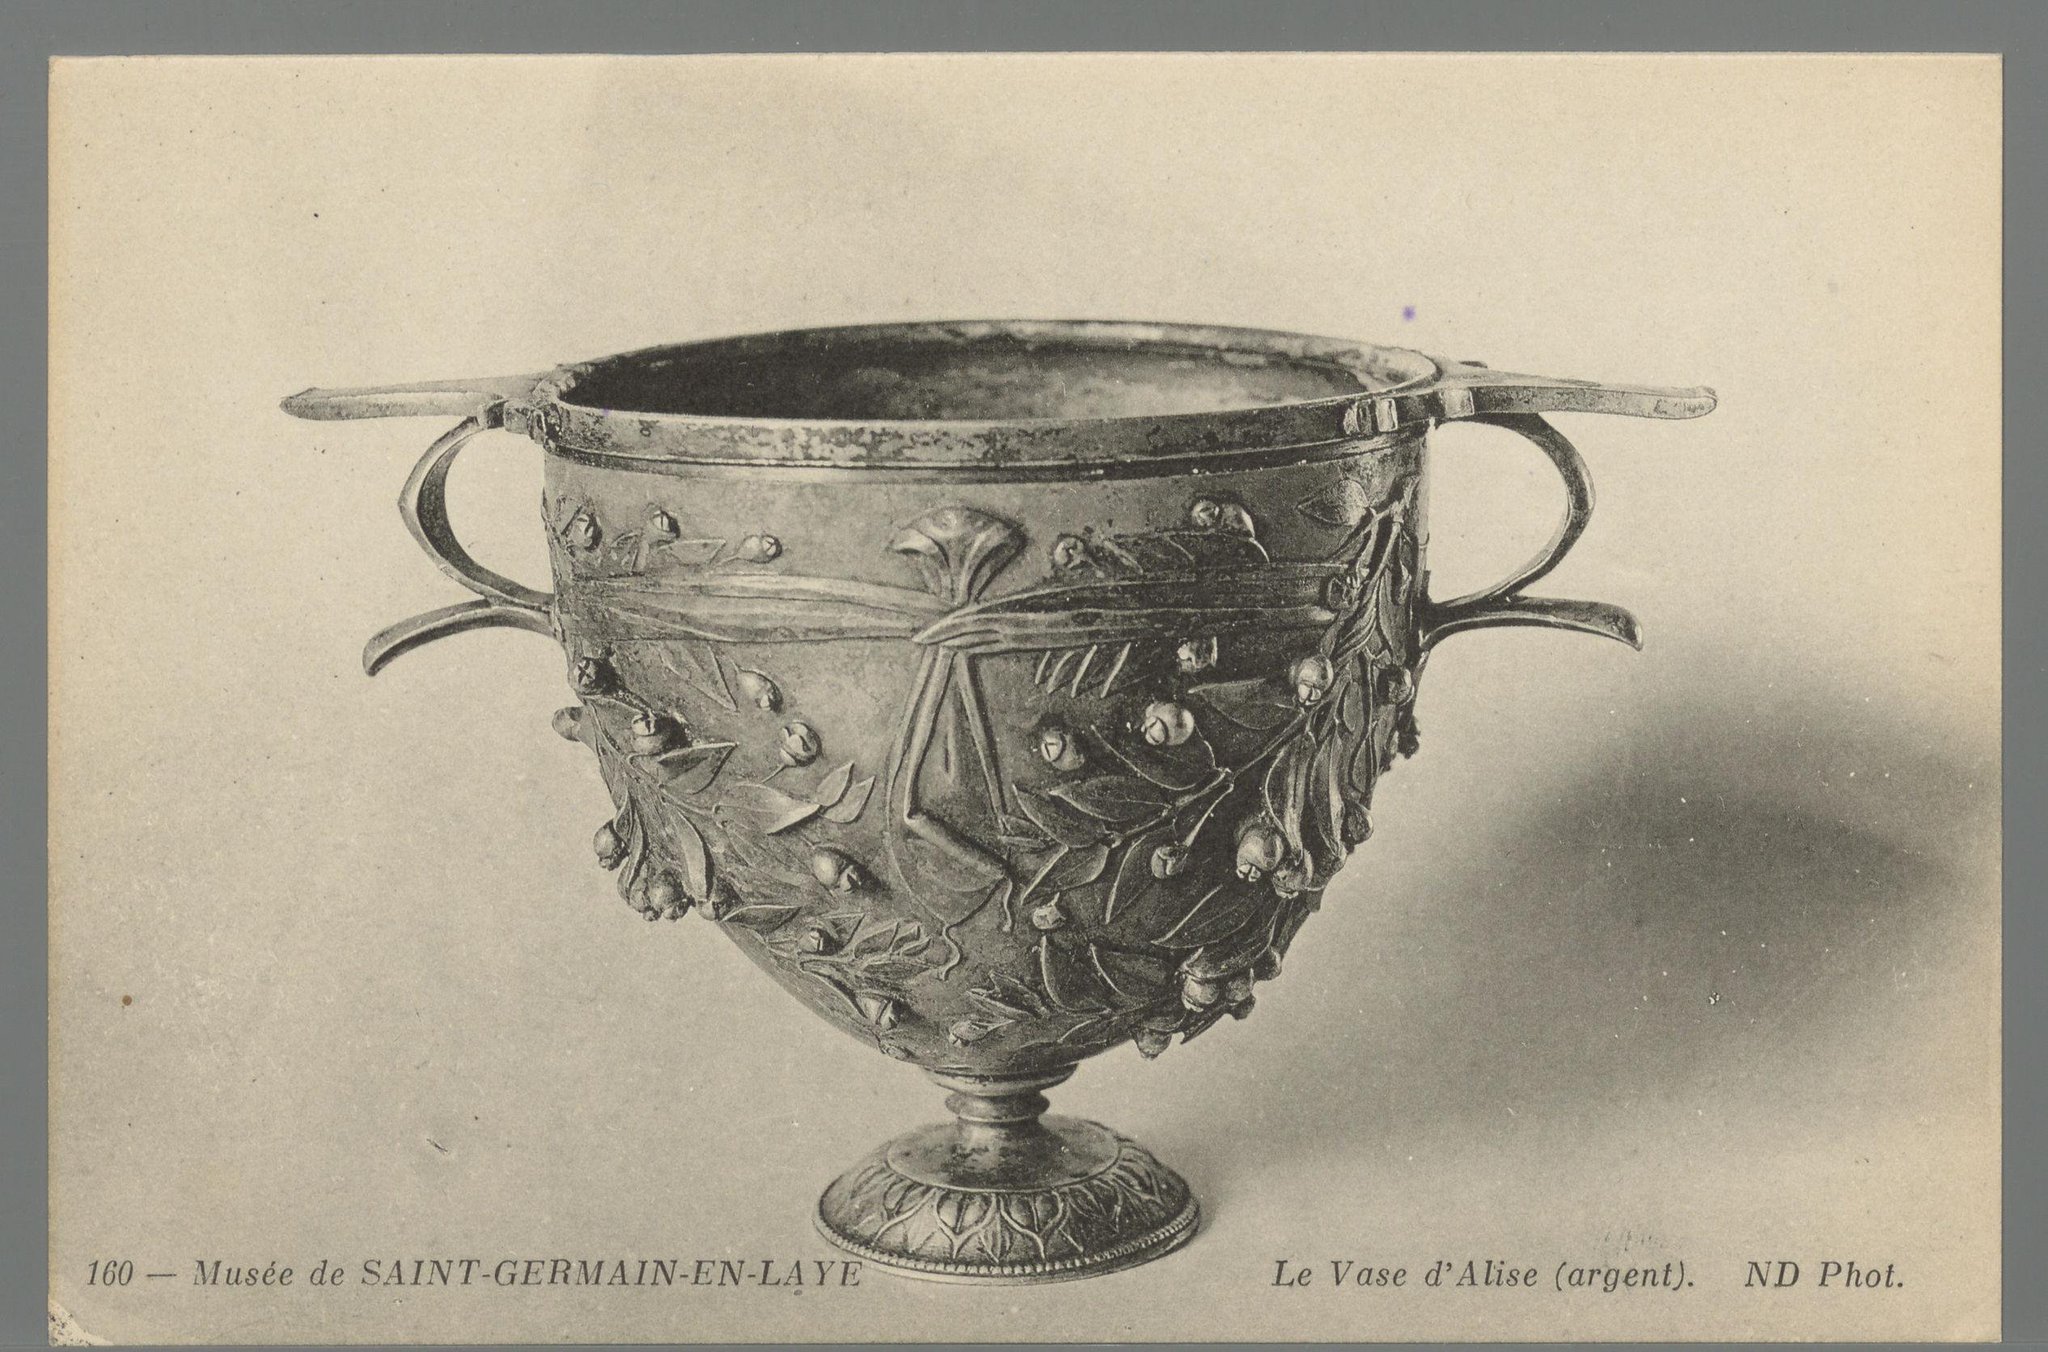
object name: photomechanical print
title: Musée de Saint-Germain-en-Laye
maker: Anonymous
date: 1903-1918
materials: cardboard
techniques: photograph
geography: paris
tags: minerals and metals: silver, vase ~ ornament, permanent exhibition, museum